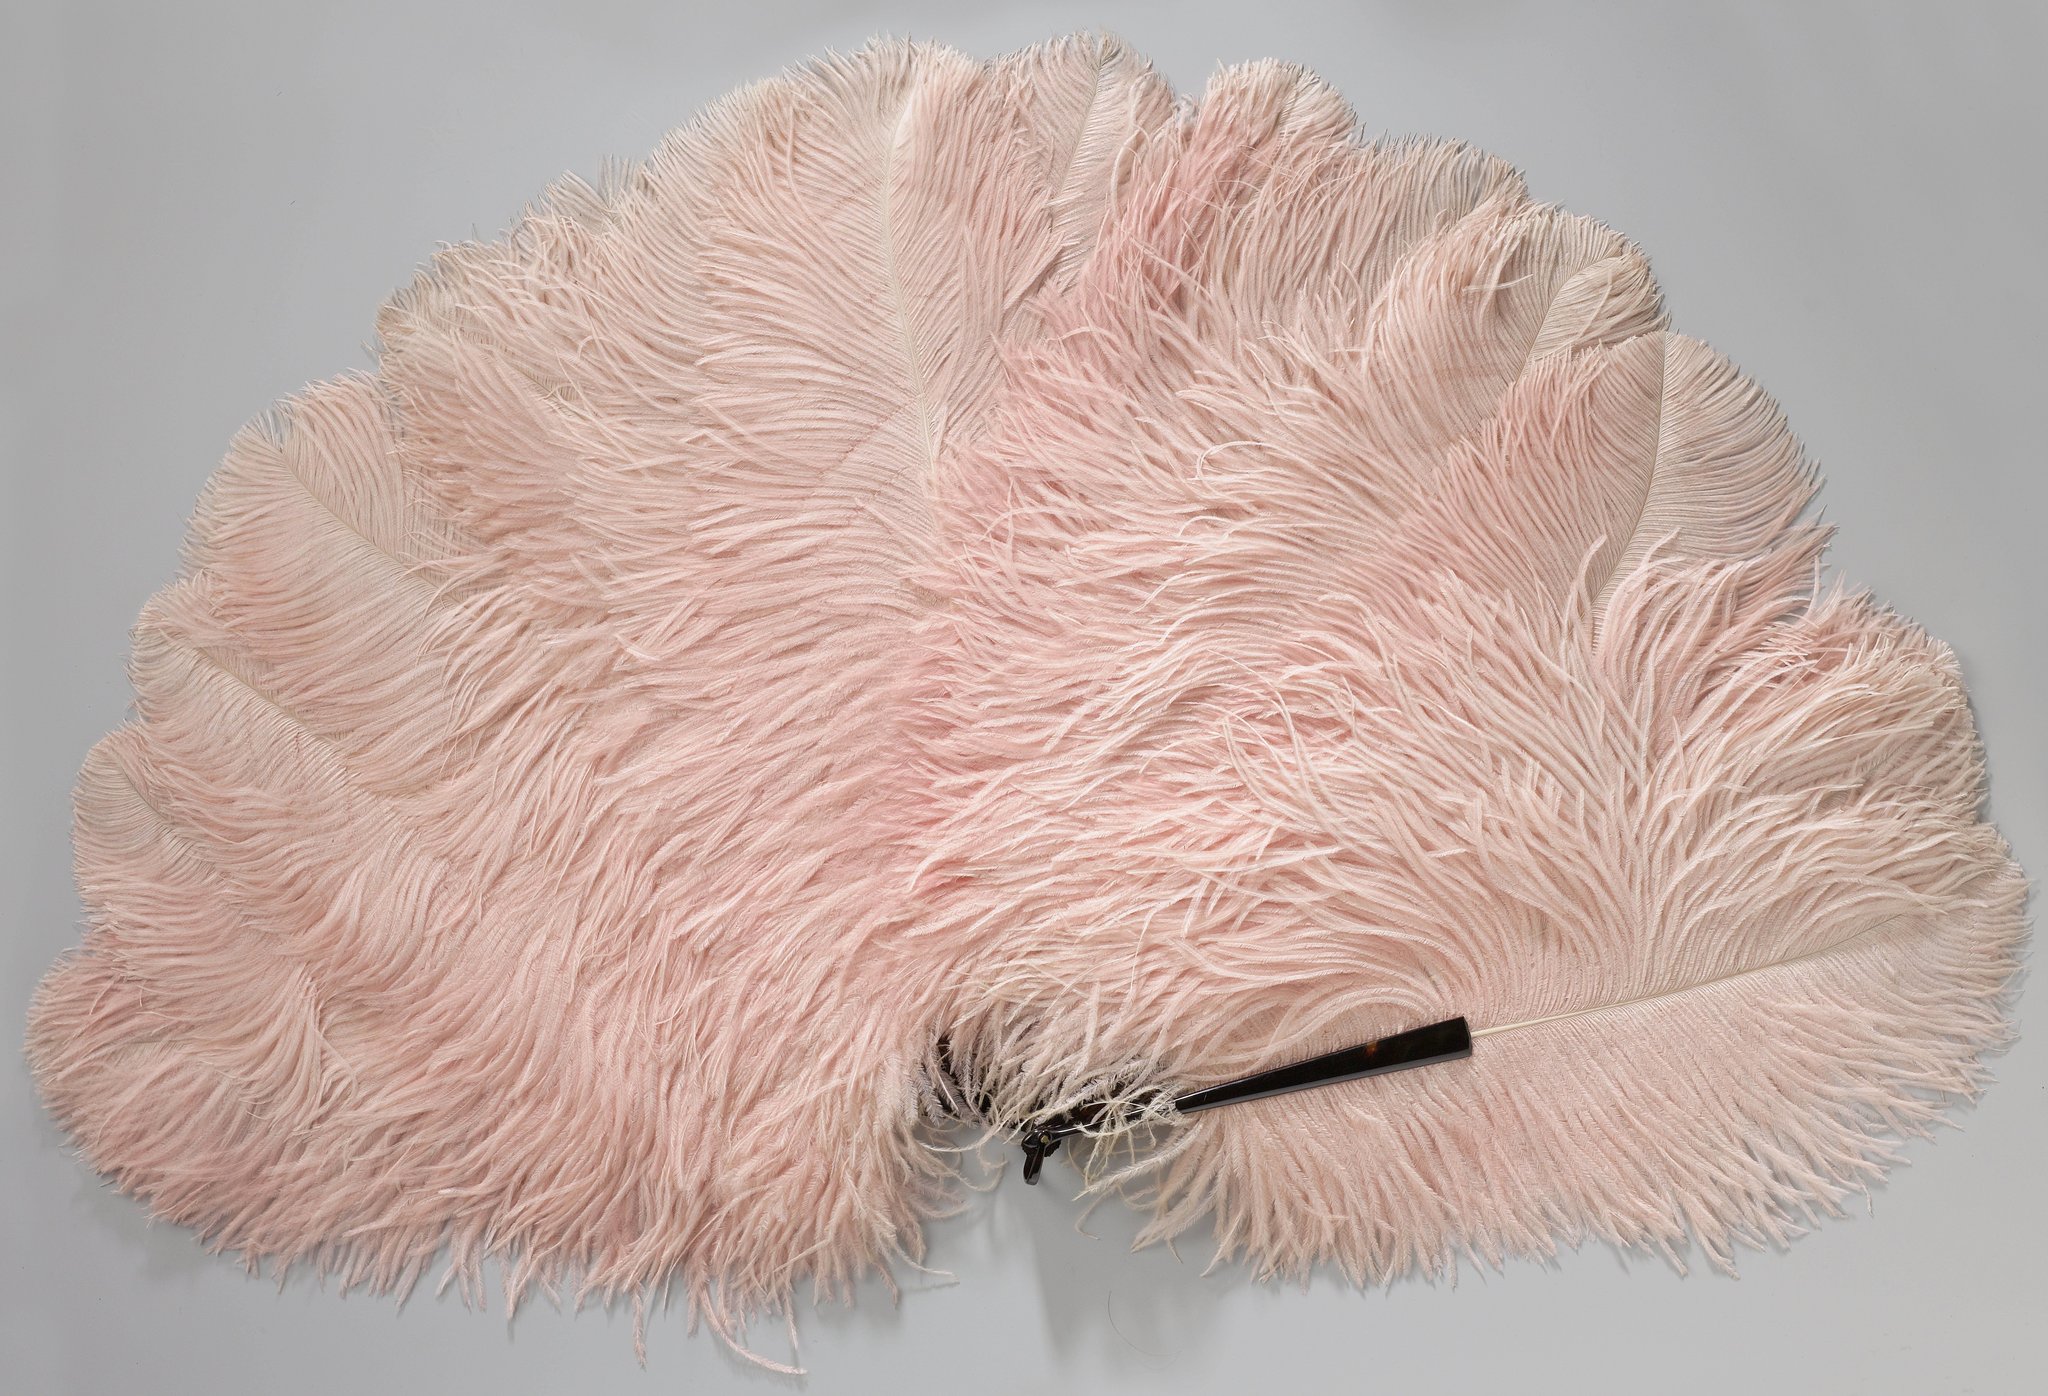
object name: vouwwaaier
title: Vouwwaaier van roze struisveren op een montuur van kunststof schildpad met dito haak met koperen sluitpin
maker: Anonymous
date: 1920-1925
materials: copper, plastic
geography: netherlands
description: Vouwwaaier van roze struisveren op een montuur van kunststof schildpad met dito haak met koperen sluitpin. Model: gesloten handdeel van 18 onversierde, gepolijste benen. Hierop zijn de struisveren met een touwtje vastgebonden. Het brede uiteinde van de buitenbenen is geschulpt.